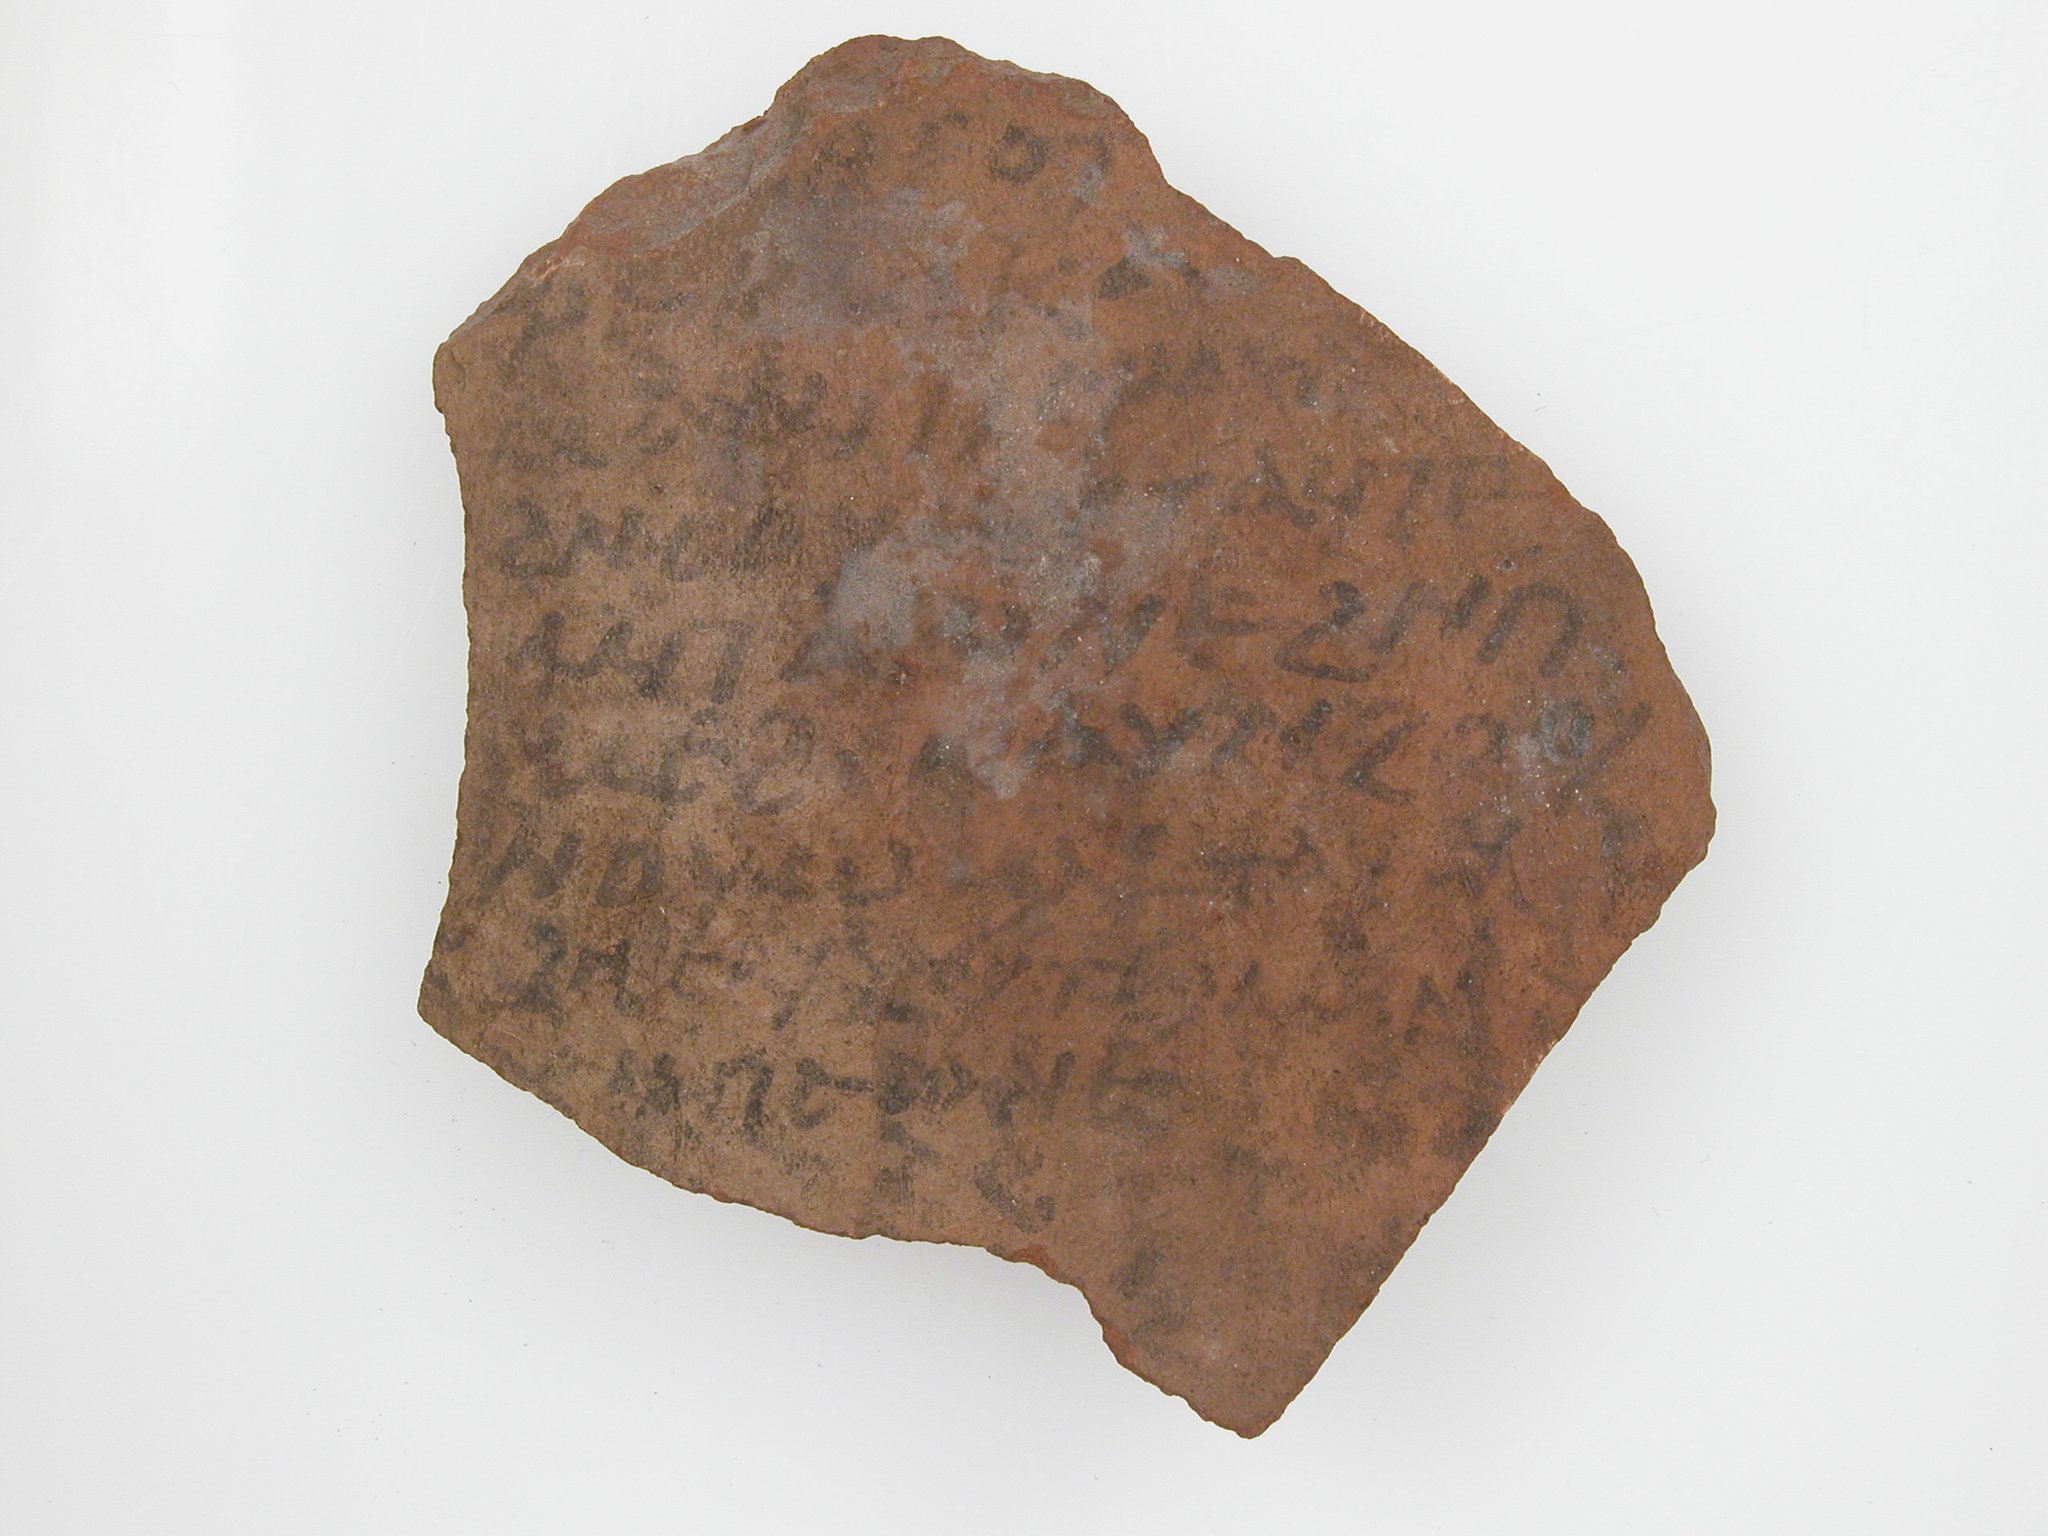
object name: ostrakon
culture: coptic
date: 601-700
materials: ink, pottery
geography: egypt